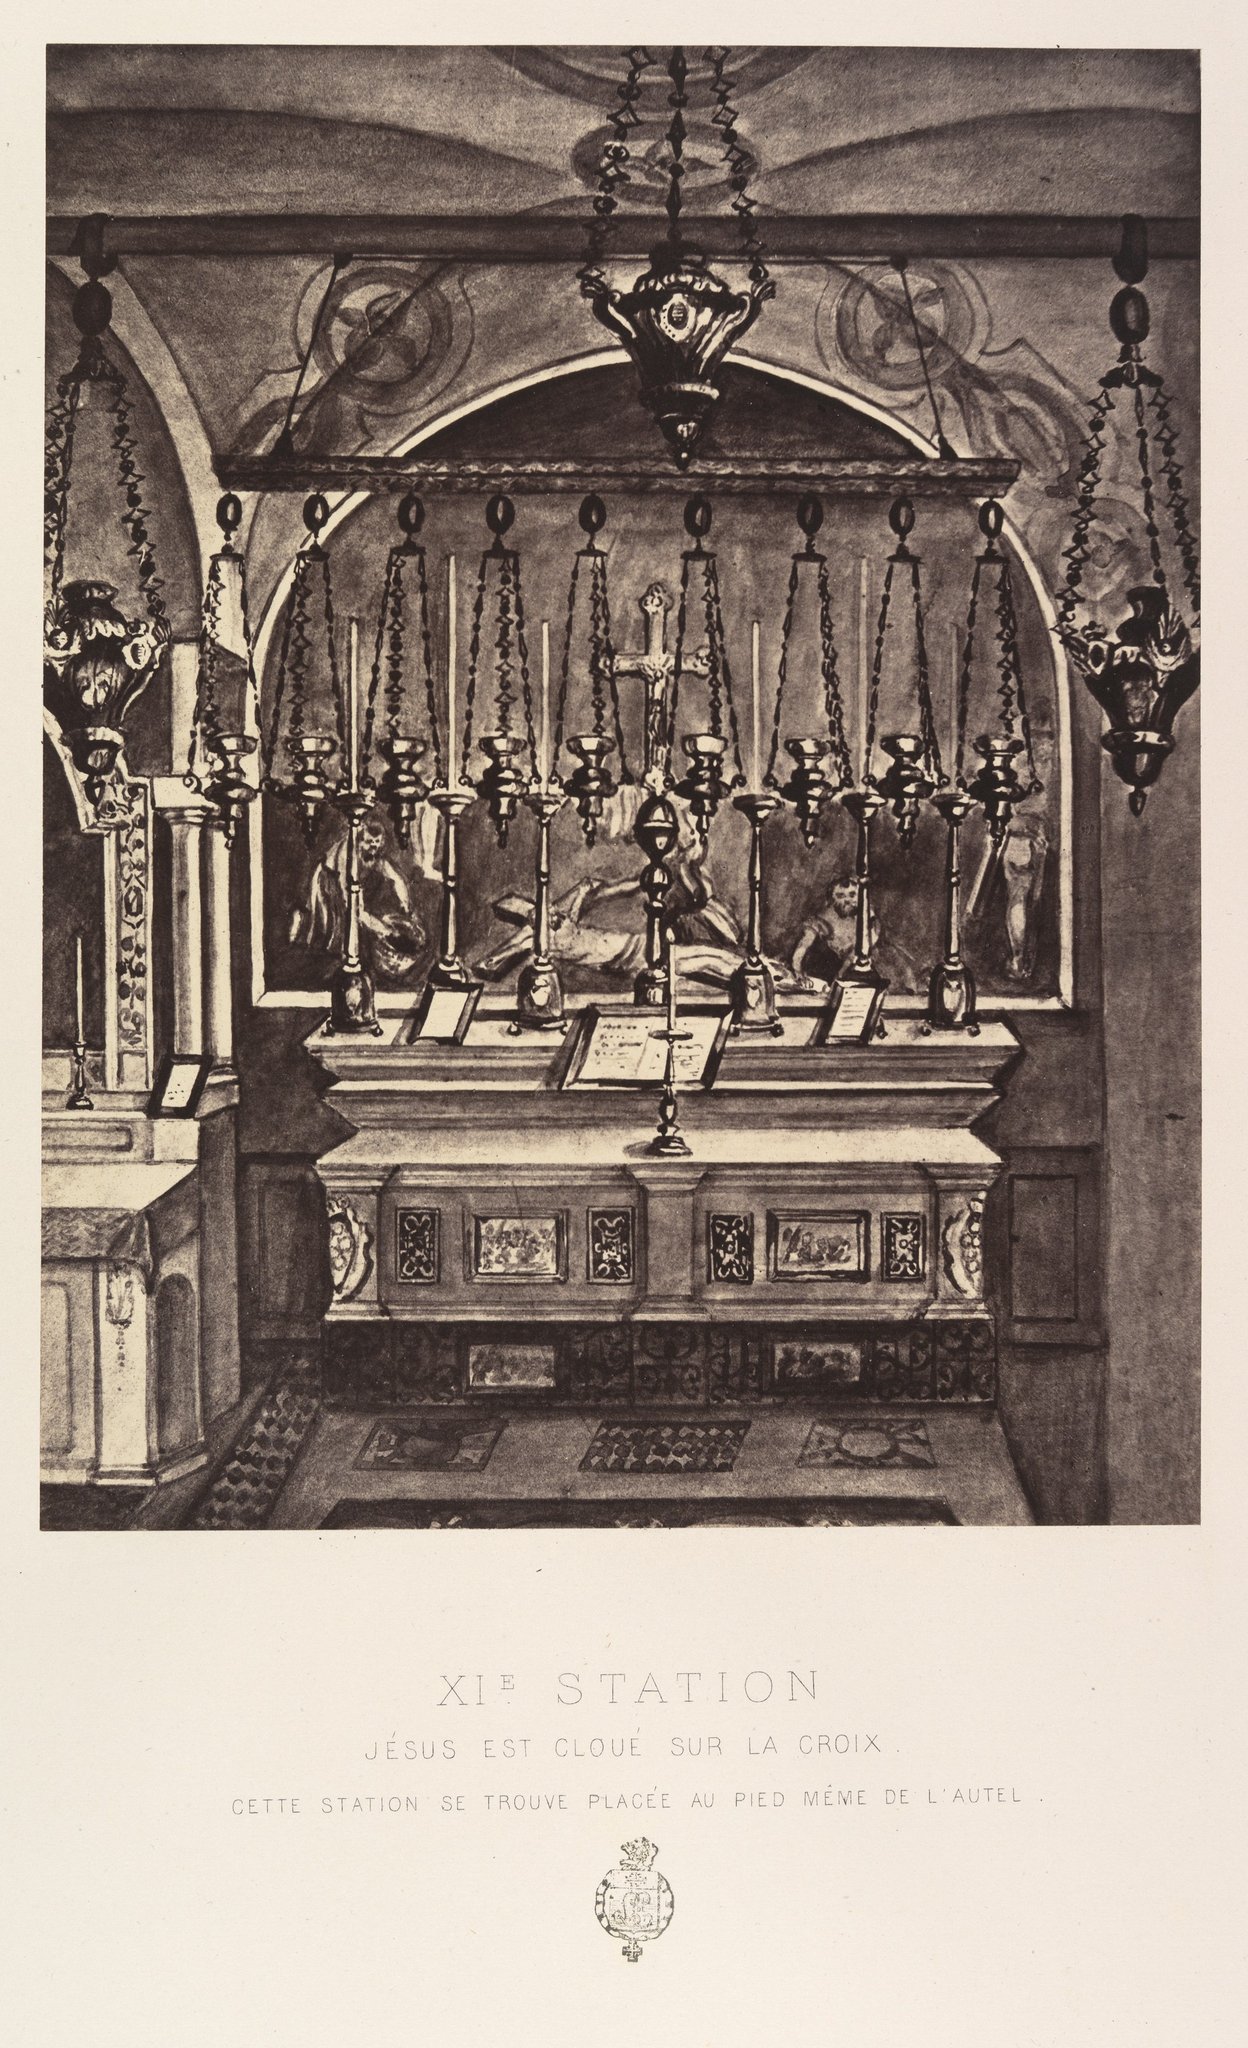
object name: photograph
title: XIe Station. Jésus est cloué sur la croix. Cette station se trouve placée au pied même de l'autel.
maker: louis de clercq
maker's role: artist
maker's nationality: french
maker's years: 1837-1901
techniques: albumen silver print, paper negative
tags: altars,cross,lamps